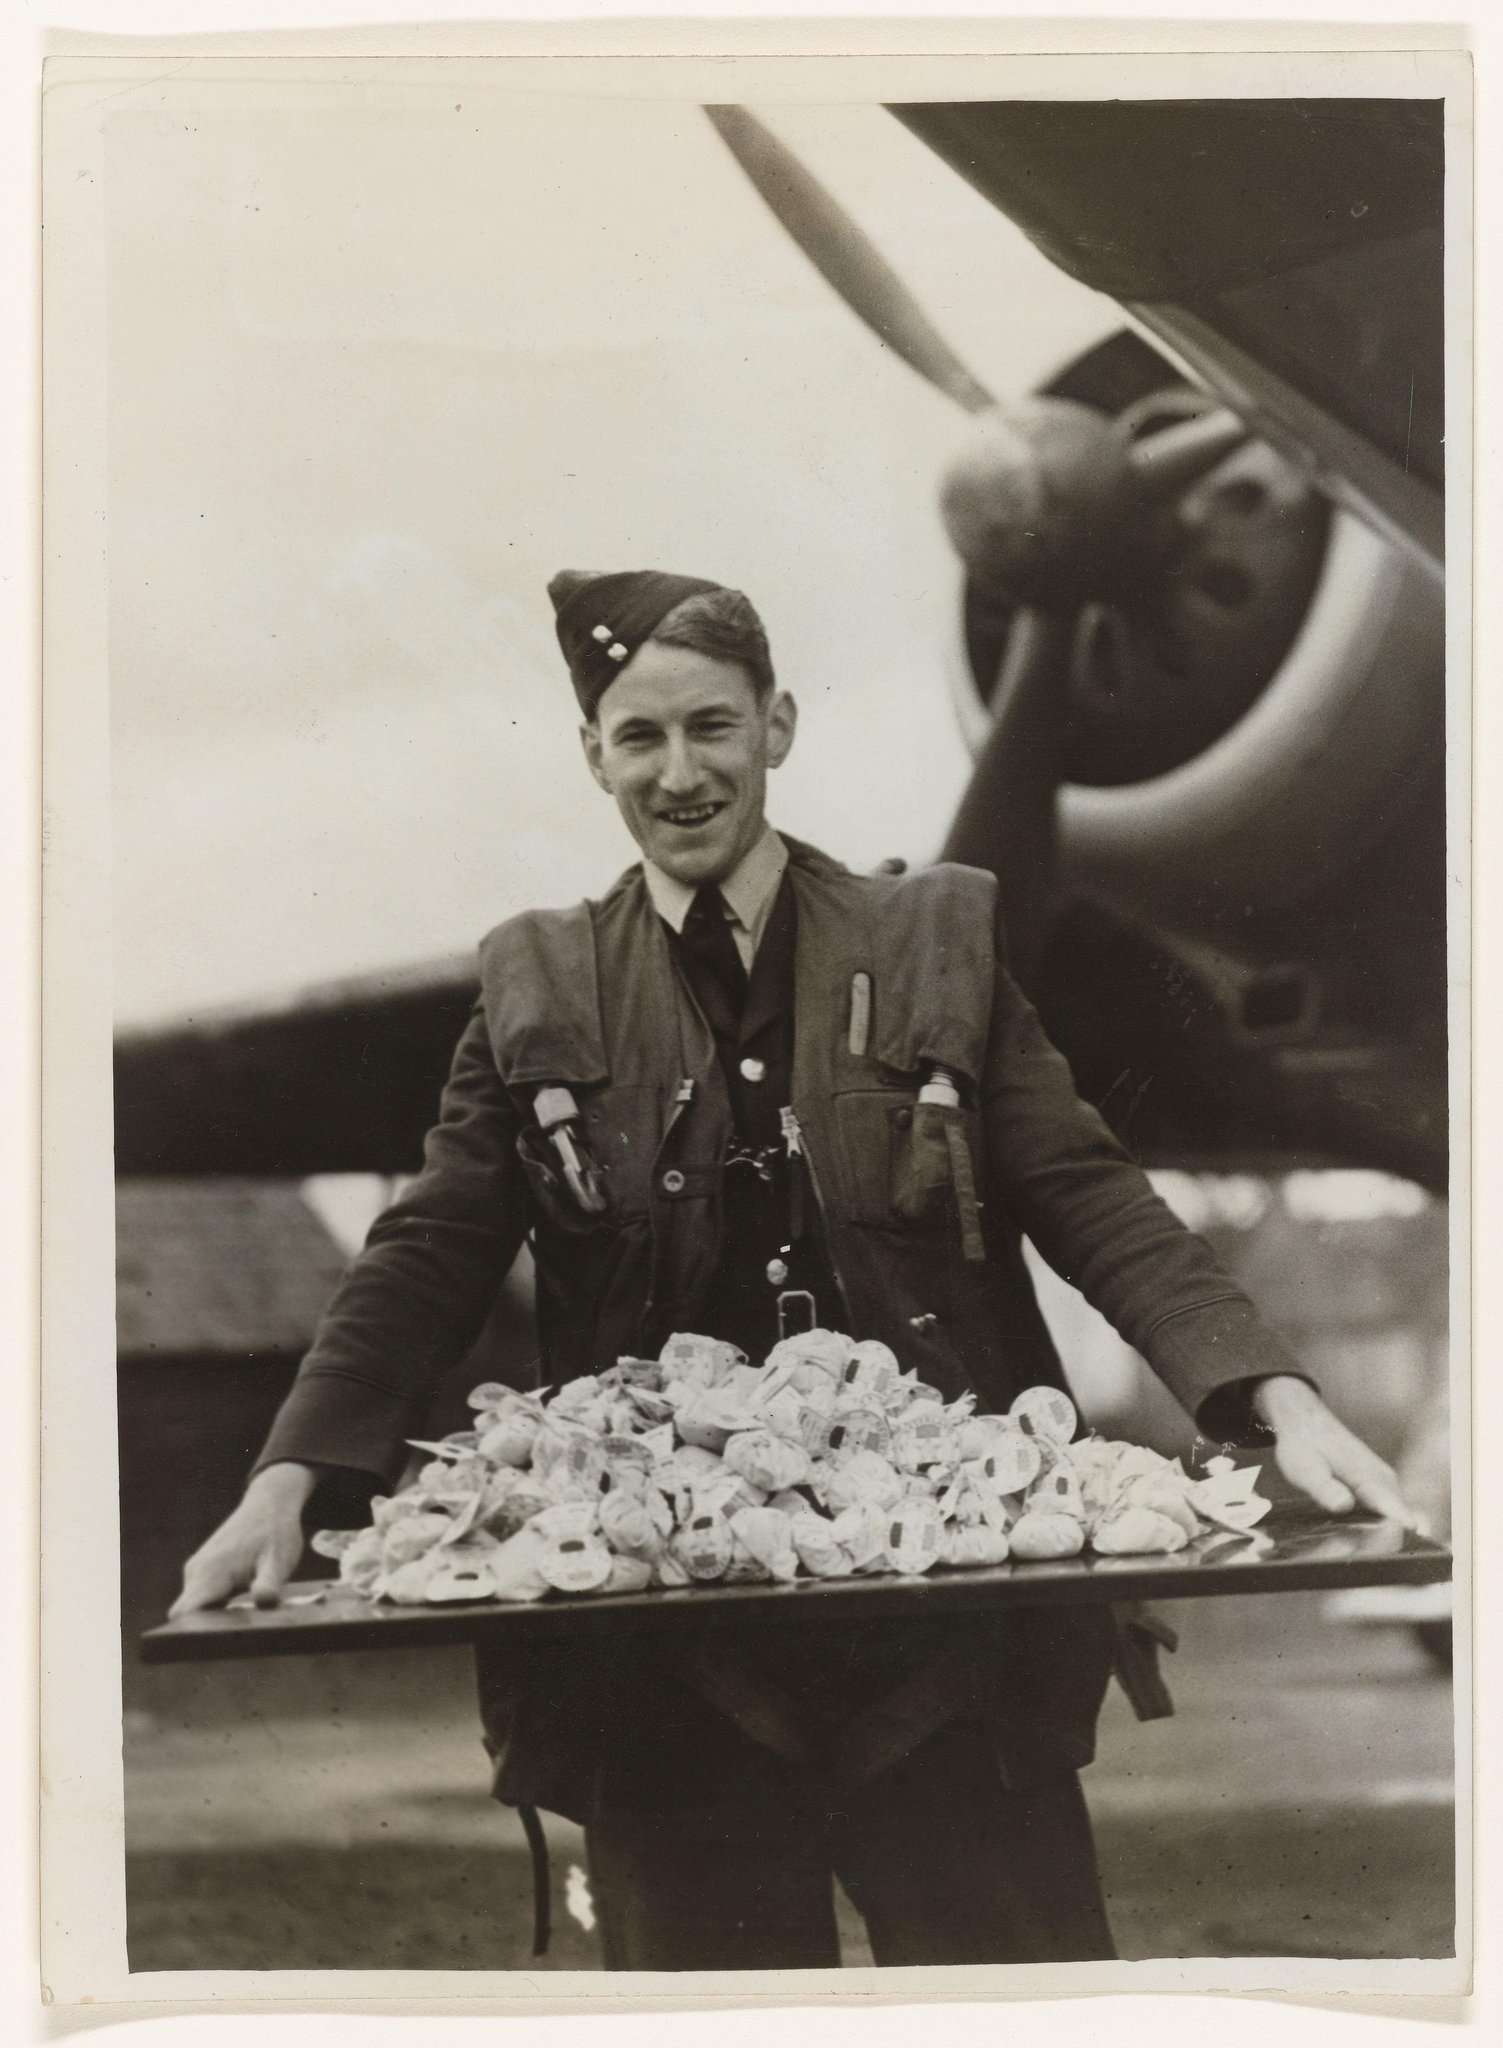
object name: photograph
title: Thee voor Nederland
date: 1940-1959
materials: photographic support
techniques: photography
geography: england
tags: england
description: Een piloot van RAF met een blad vol met theezakjes. Deze zakjes werden tijdens een vlucht door de RAF naar Duitsland uitgeworpen boven Nederland als groet uit het toen nog vrije Nederlands-Indië.